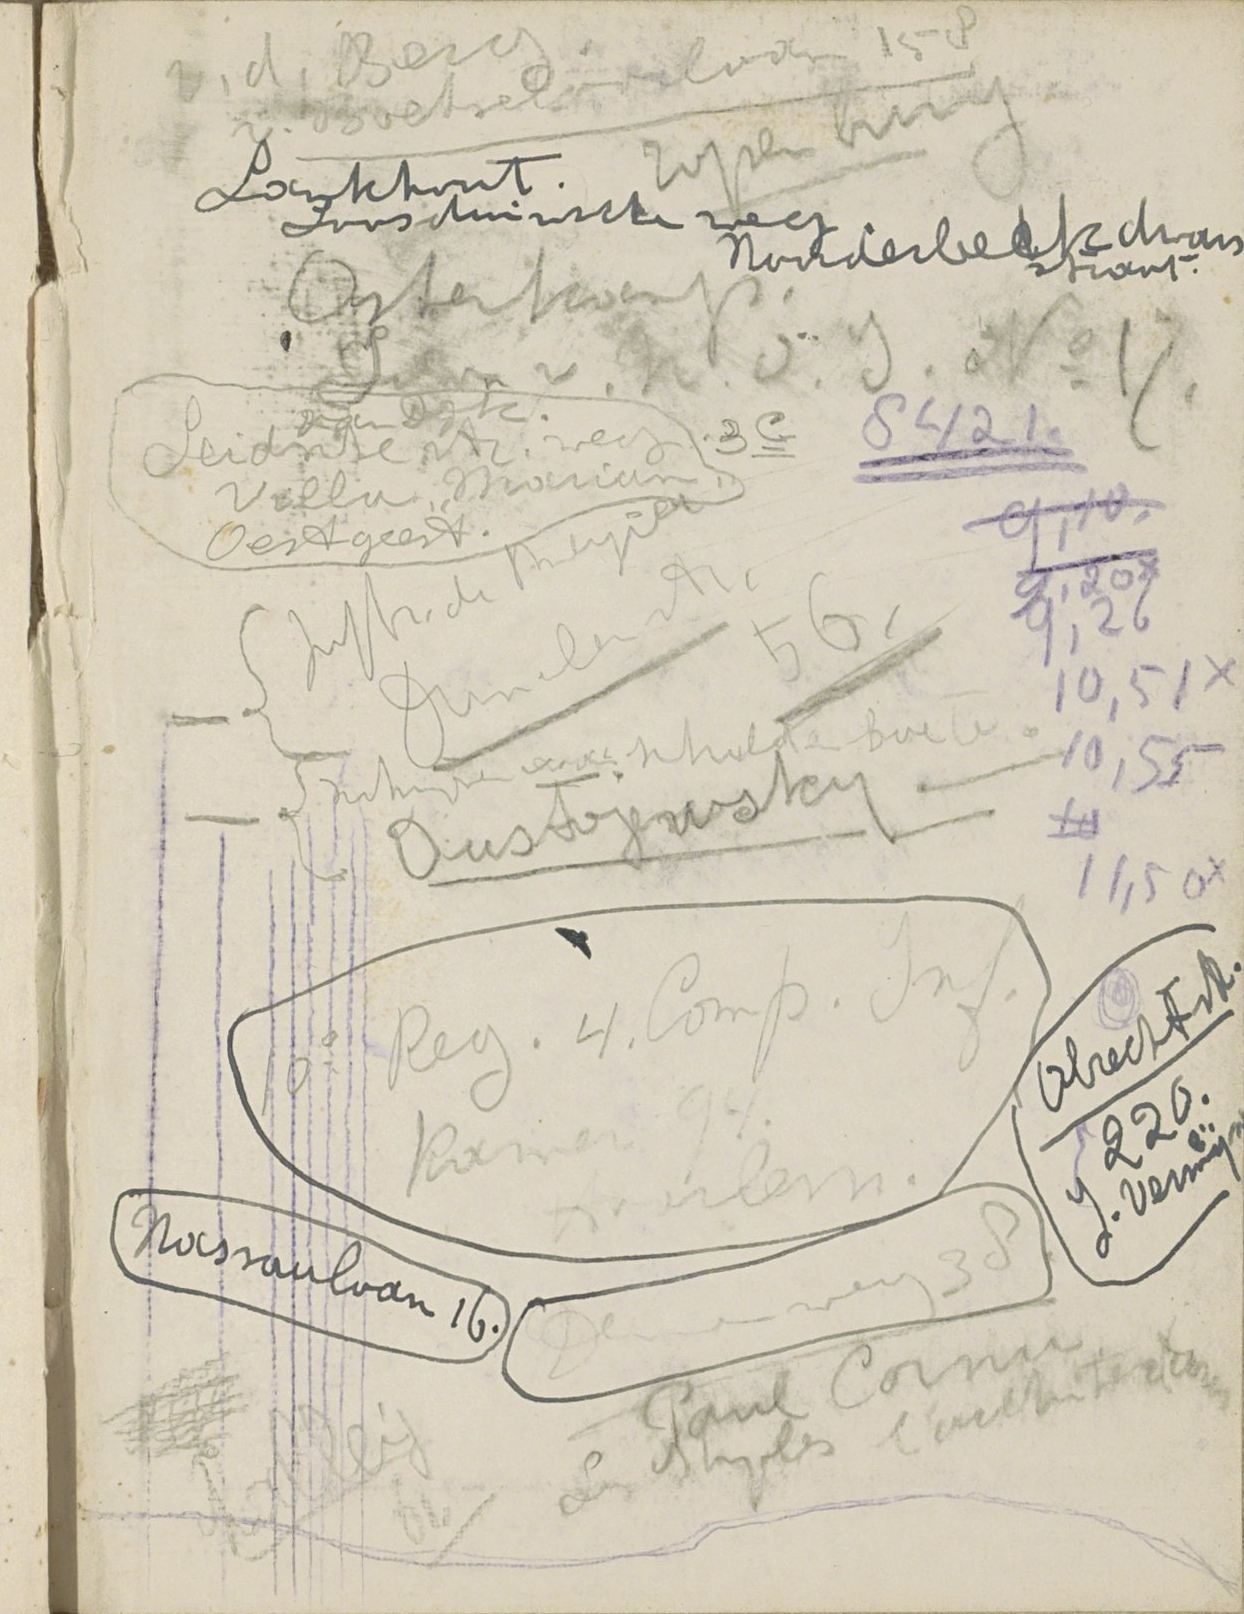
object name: endleaf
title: Notities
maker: reijer stolk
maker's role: draughtsman, print maker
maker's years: 1896-1945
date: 1906-1945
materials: ink, paper, pencil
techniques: pen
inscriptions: annotation: ‘[...]’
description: Achterste schutblad uit een schetsboek met 69 bladen.